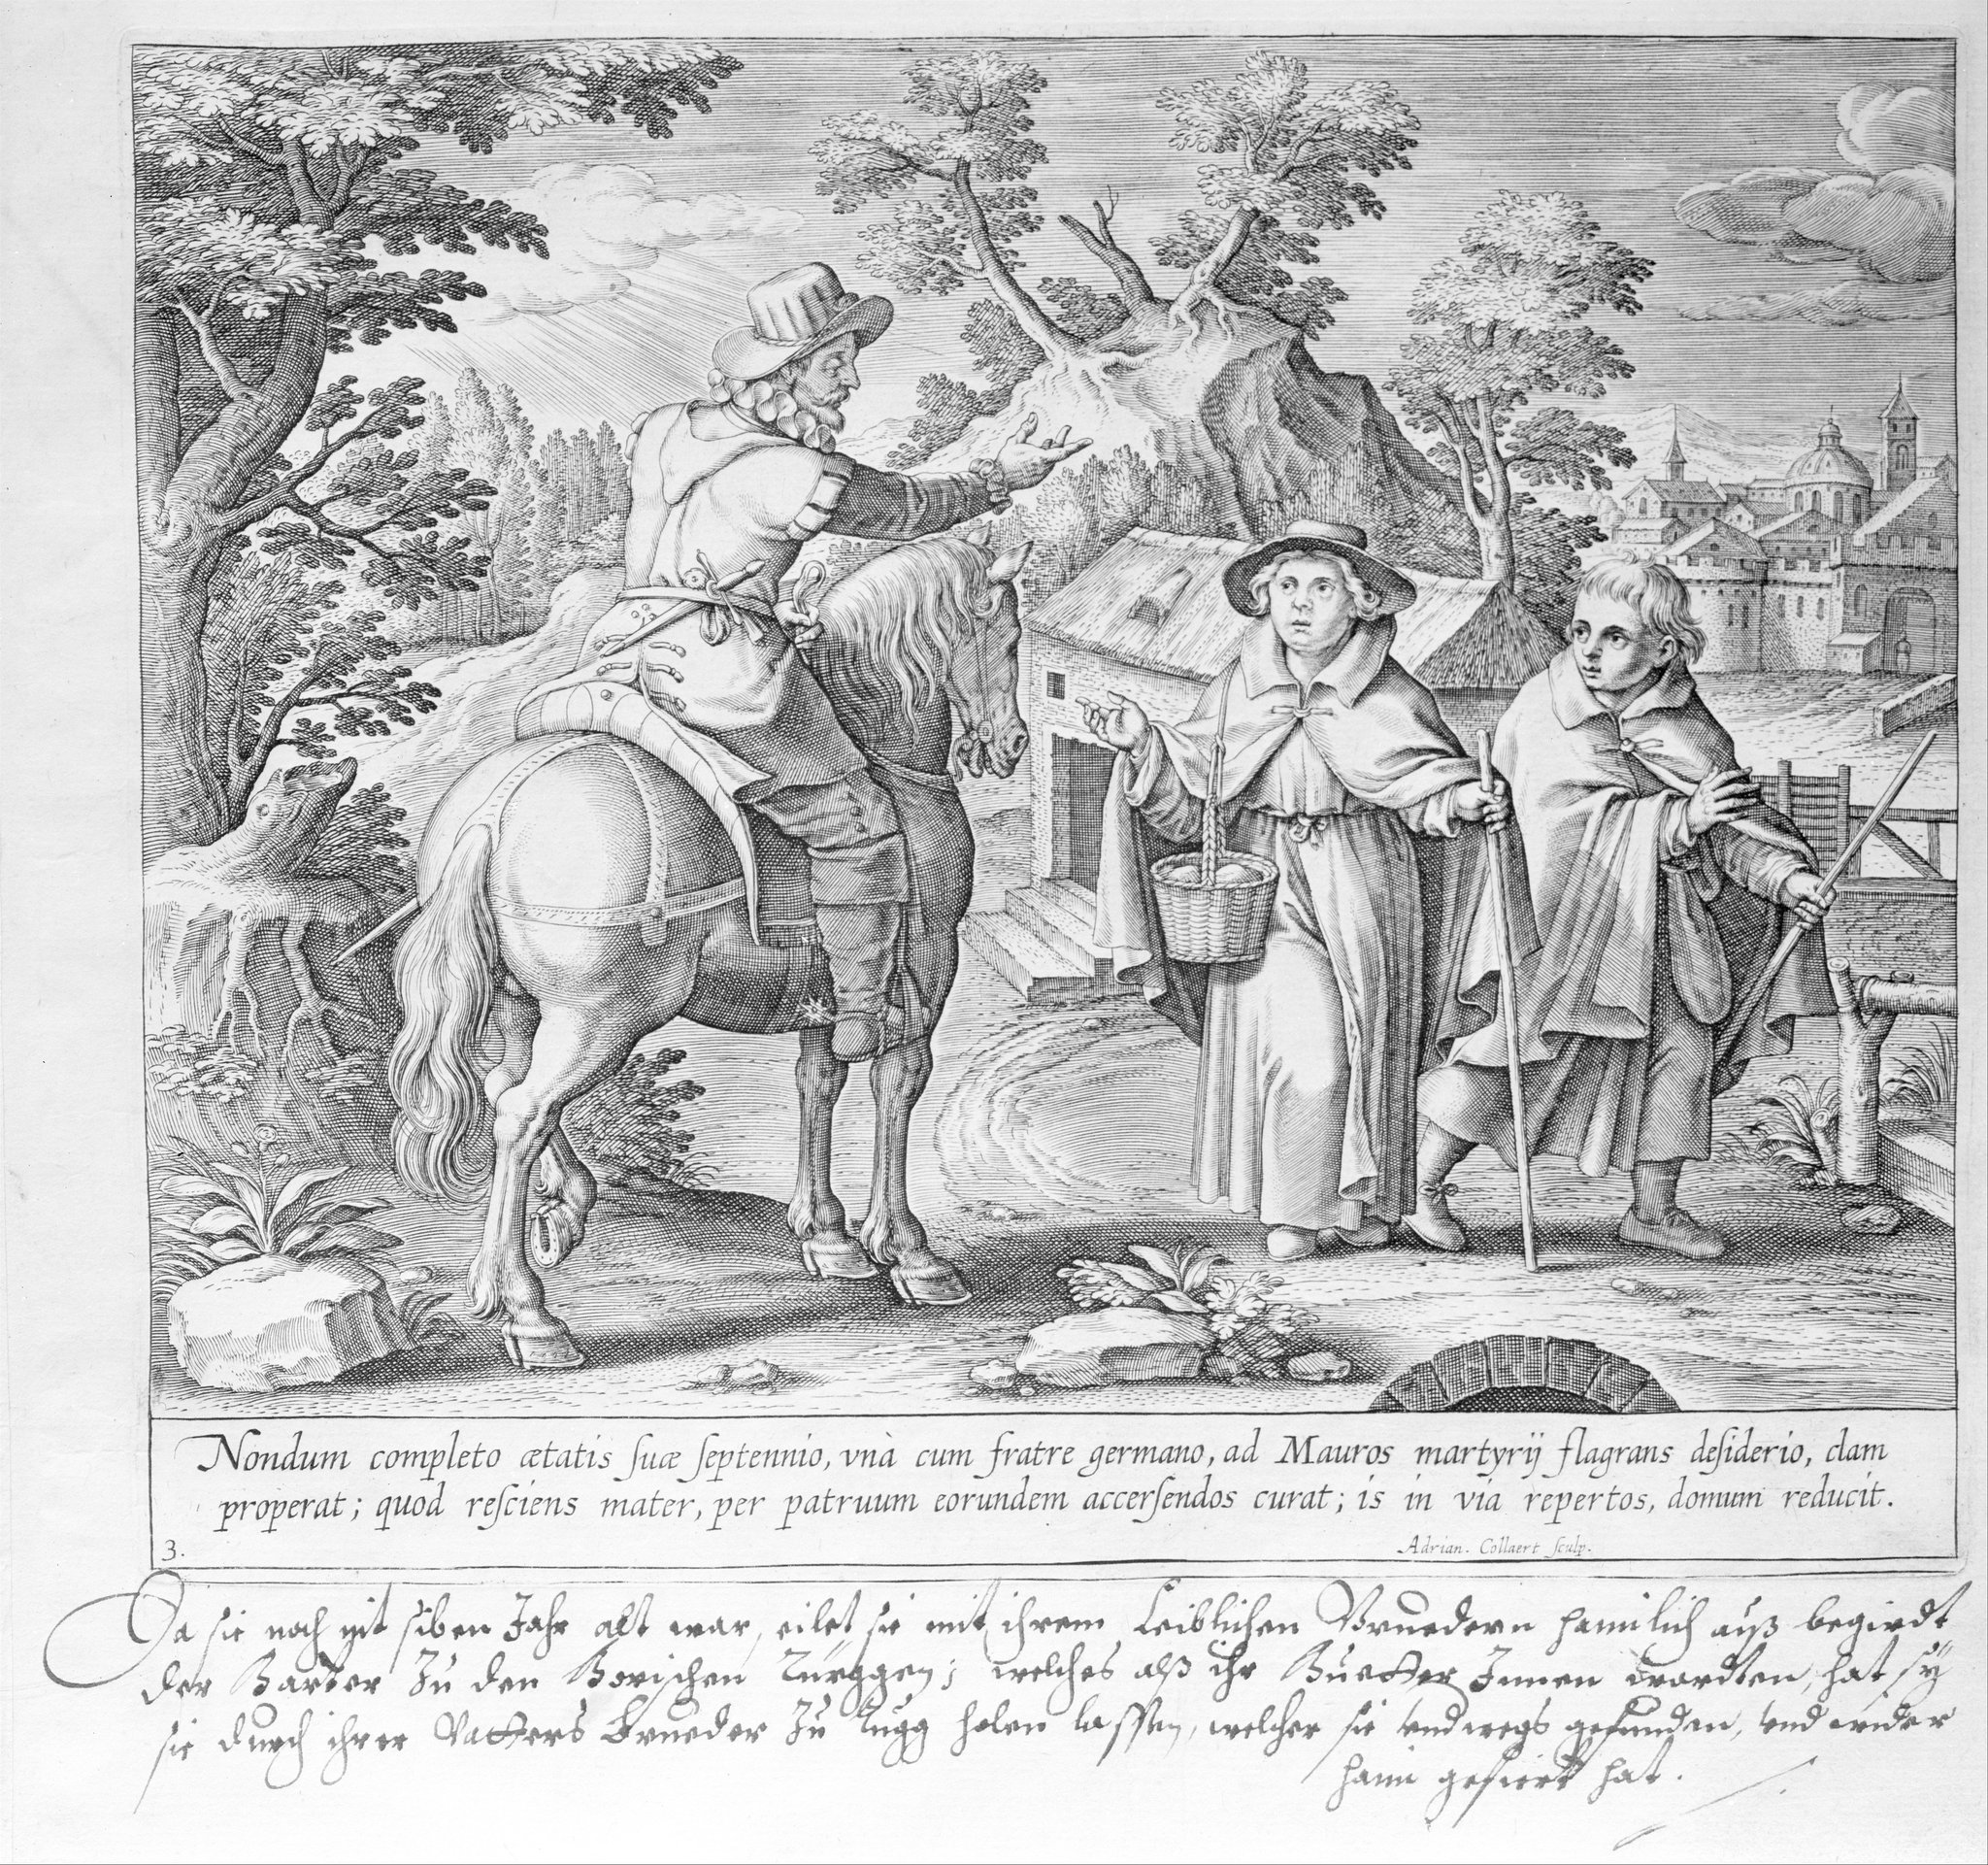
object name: book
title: Vita B. Virginis Teresiae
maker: adriaen collaert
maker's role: artist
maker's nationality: netherlandish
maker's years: 1560-1618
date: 1613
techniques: engraving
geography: flanders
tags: houses,horses,trees